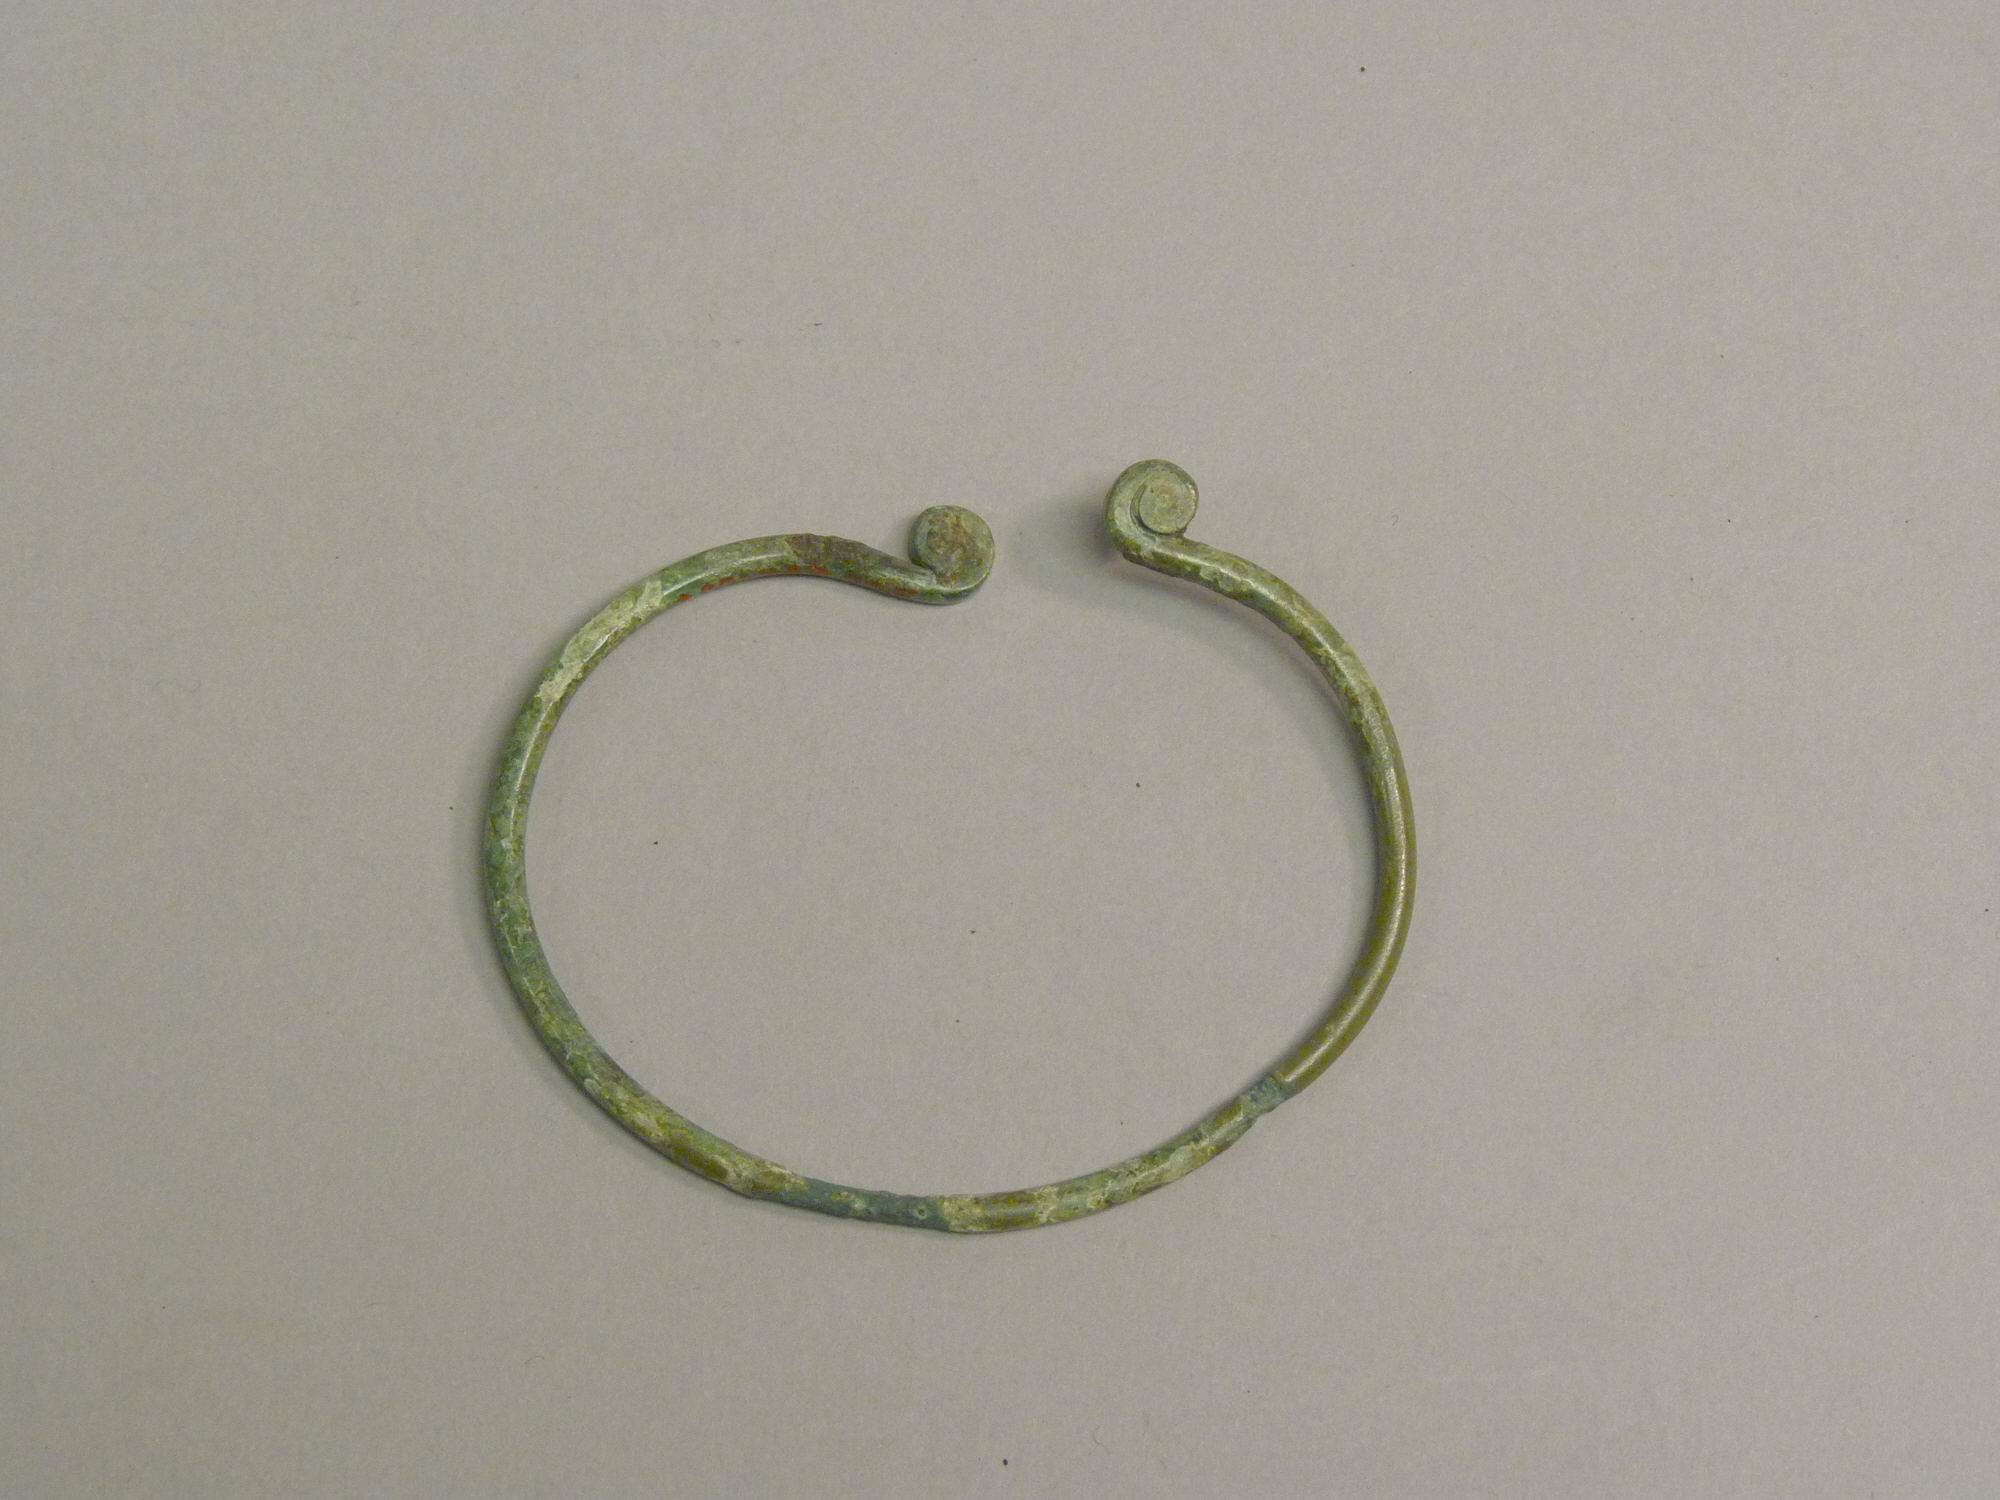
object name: one of a pair of bangle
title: One from a Pair of Wire Bangles with Twisted End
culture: thai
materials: bronze